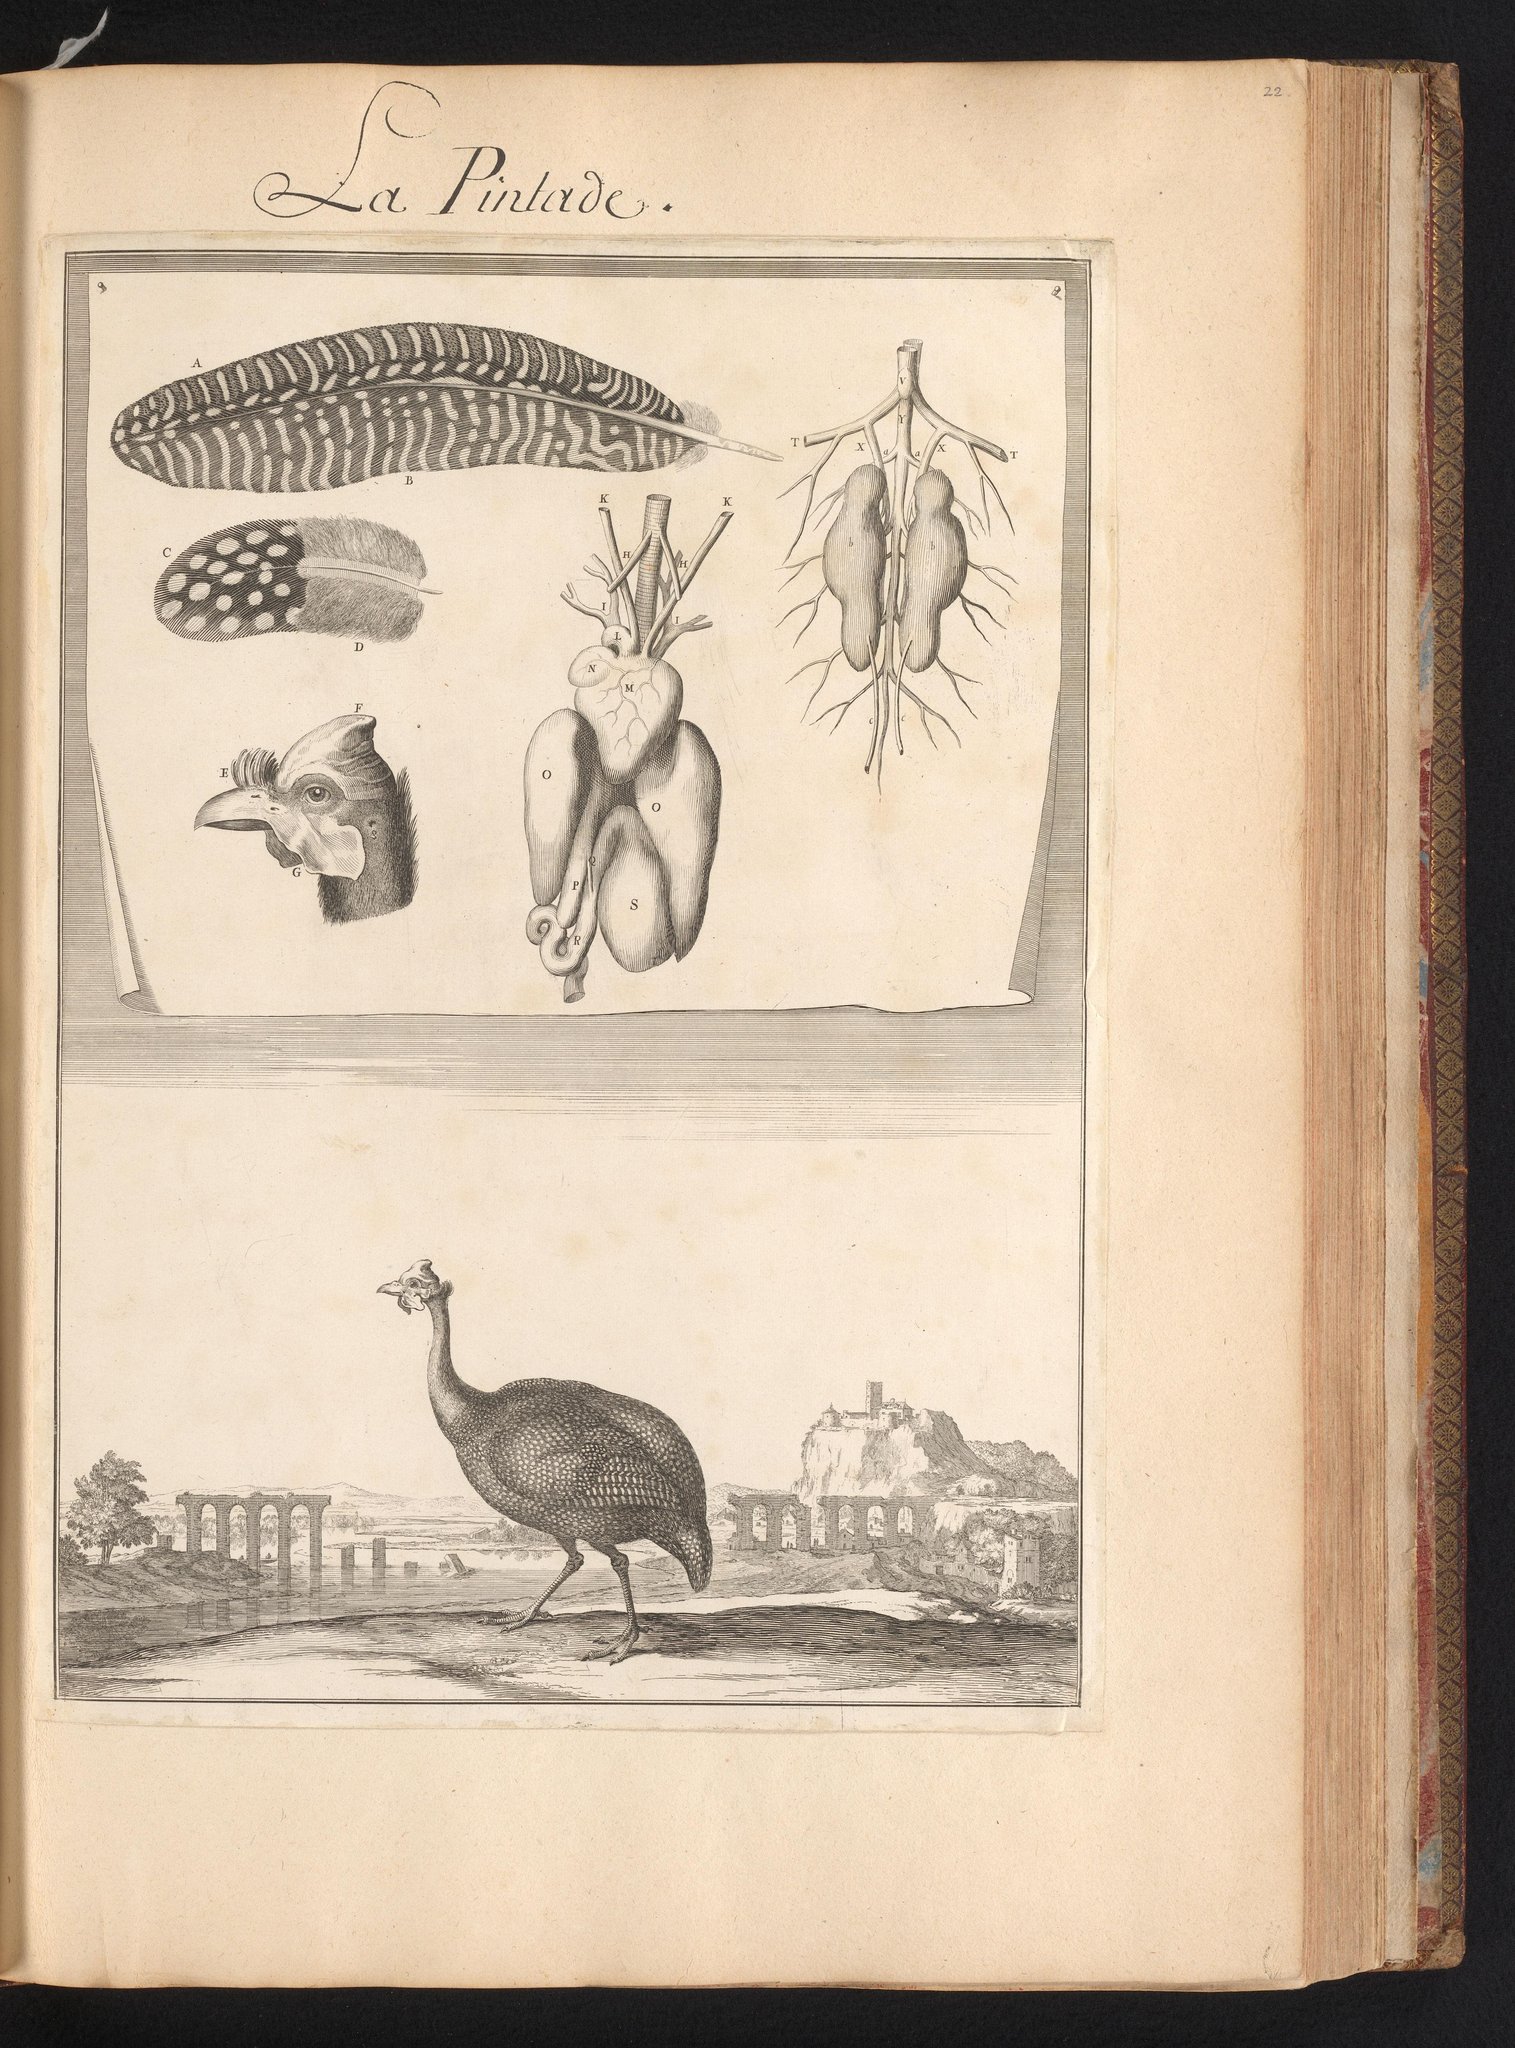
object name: album leaf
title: Parelhoen (numididae) in een landschap met bovenaan op een blad de organen en veren van het dier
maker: sébastien leclerc (i)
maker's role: print maker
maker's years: 1637-1714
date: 1676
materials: ink, paper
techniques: engraving, etching, pen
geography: paris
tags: dissection, walker and runner birds, animals (+ anatomy of animals)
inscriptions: inscription: ‘La Pintade.’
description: Prent uit: Perrault, Claude. Mémoires pour servir à l'histoire naturelle des animaux. Dressez par M. Perrault de l'Académie Royale des Sciences (...). Parijs: Imprimerie Royale, 1676.